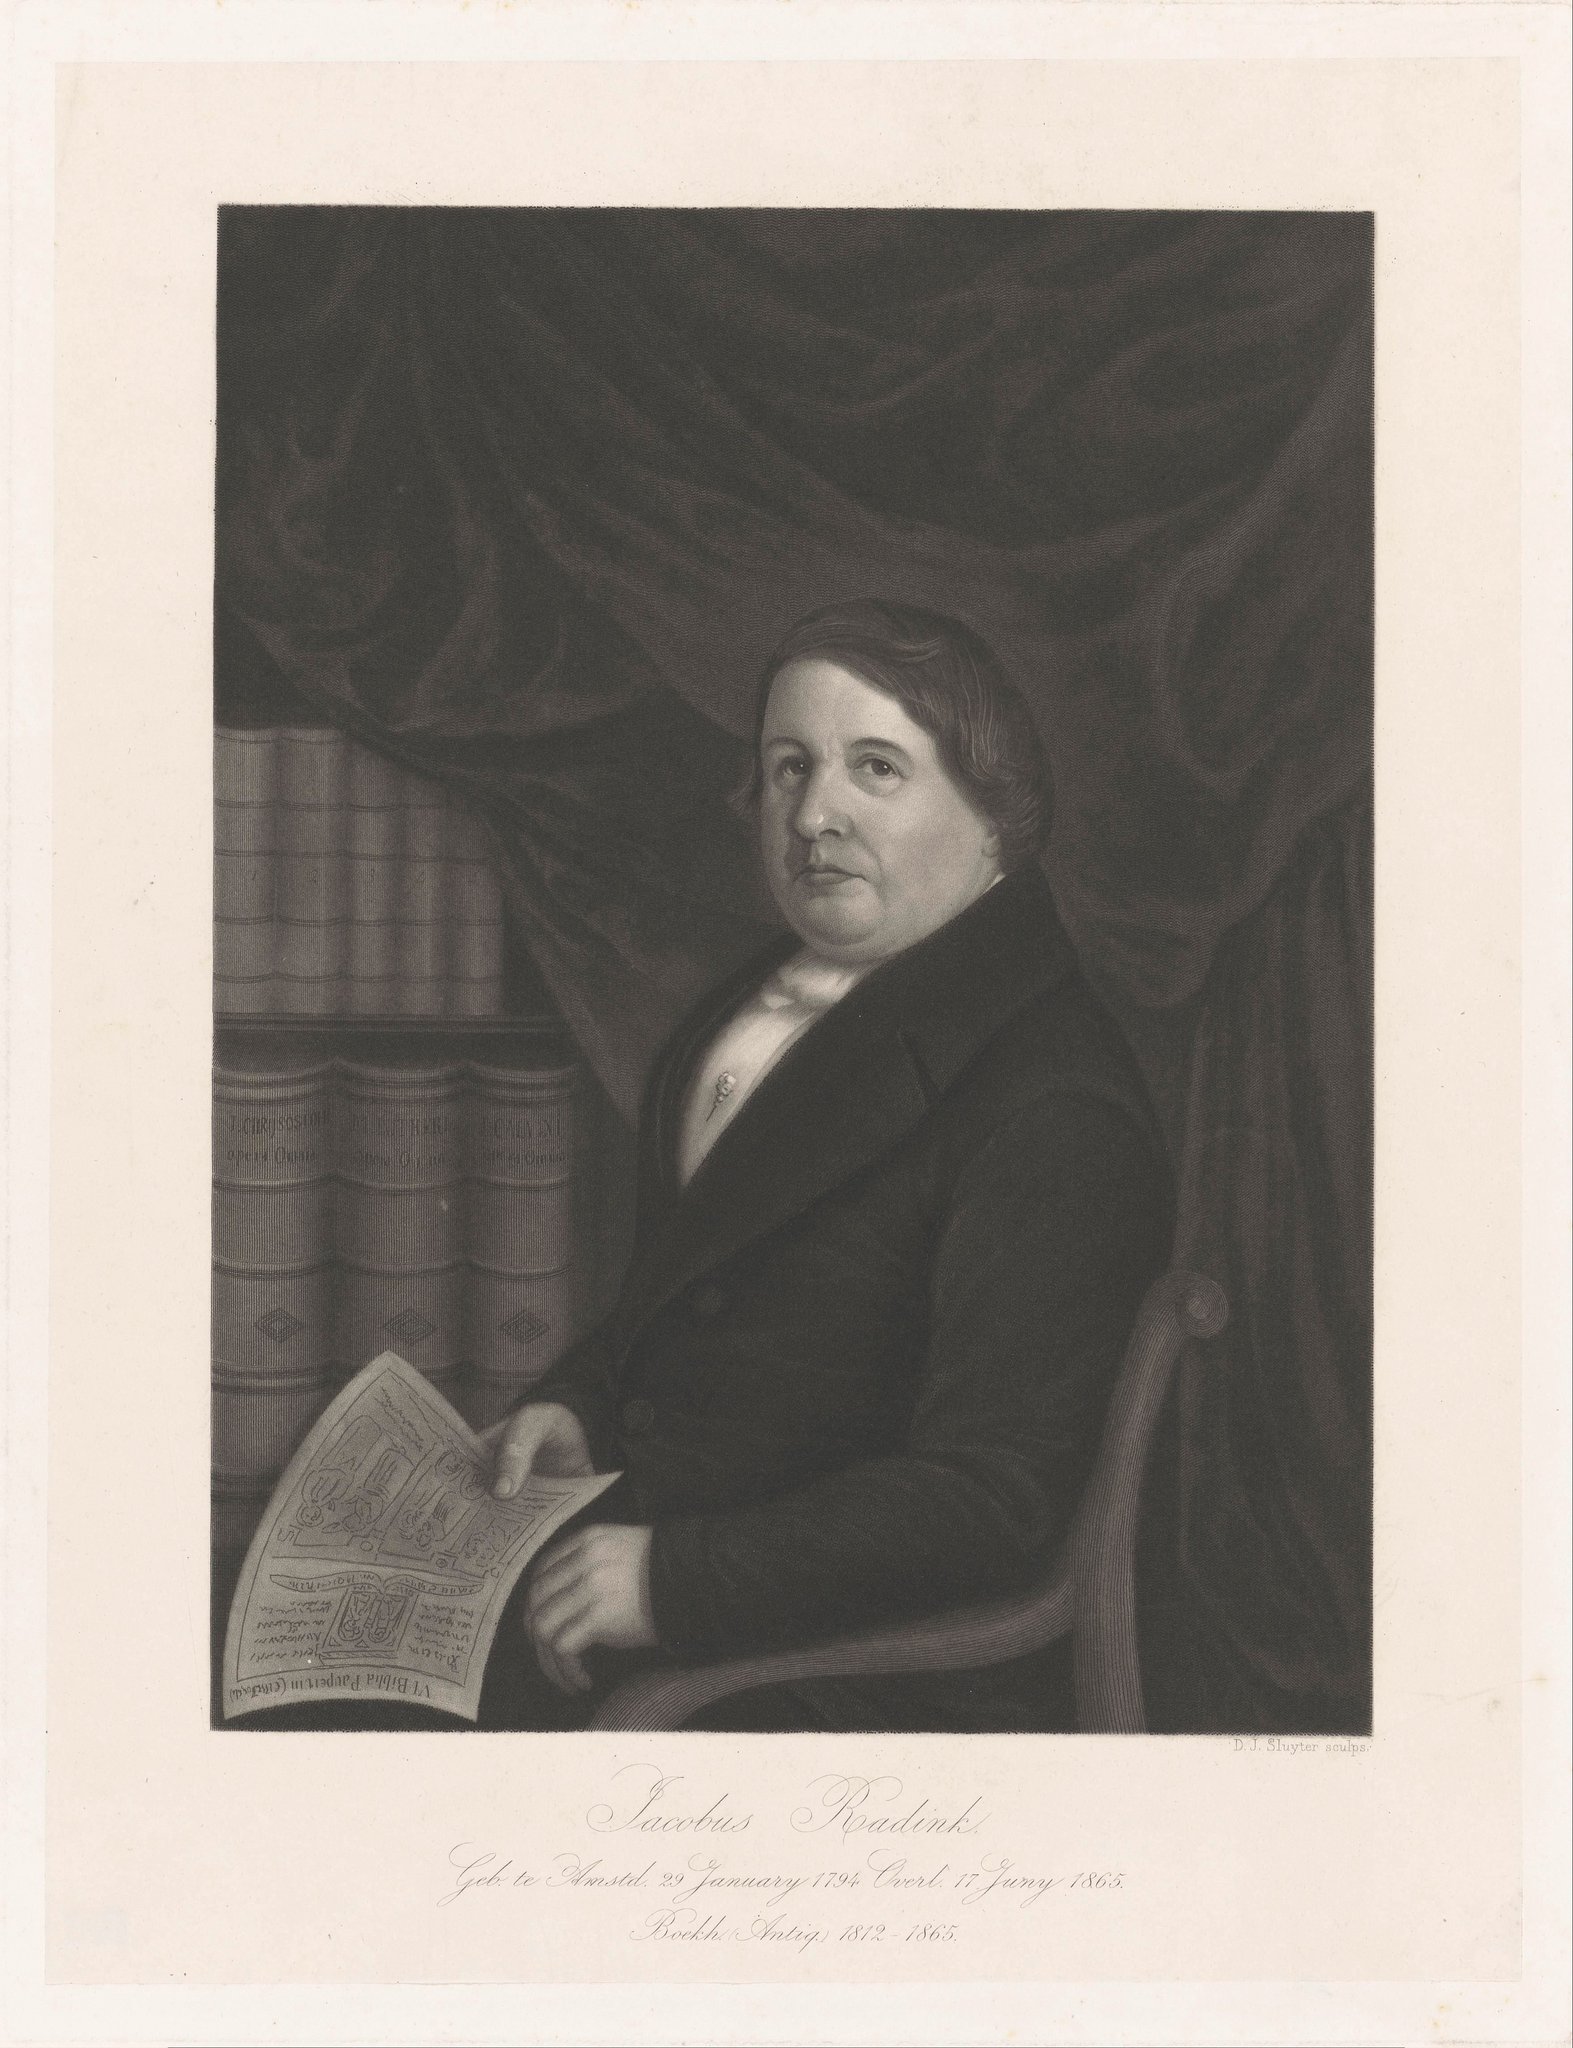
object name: print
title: Portret van Jacobus Radink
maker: dirk jurriaan sluyter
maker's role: draughtsman, print maker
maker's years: 1811-1886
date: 1865-1886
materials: paper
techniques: etching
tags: jacobus radink, book, book-shop, bookseller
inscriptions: collector's mark: Lugt 4779, collector's mark: Lugt 2228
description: De boekhandelaar en uitgever Jacobus Radink zit voor een boekenkast. In zijn hand heeft hij een blad uit een Biblia pauperum.